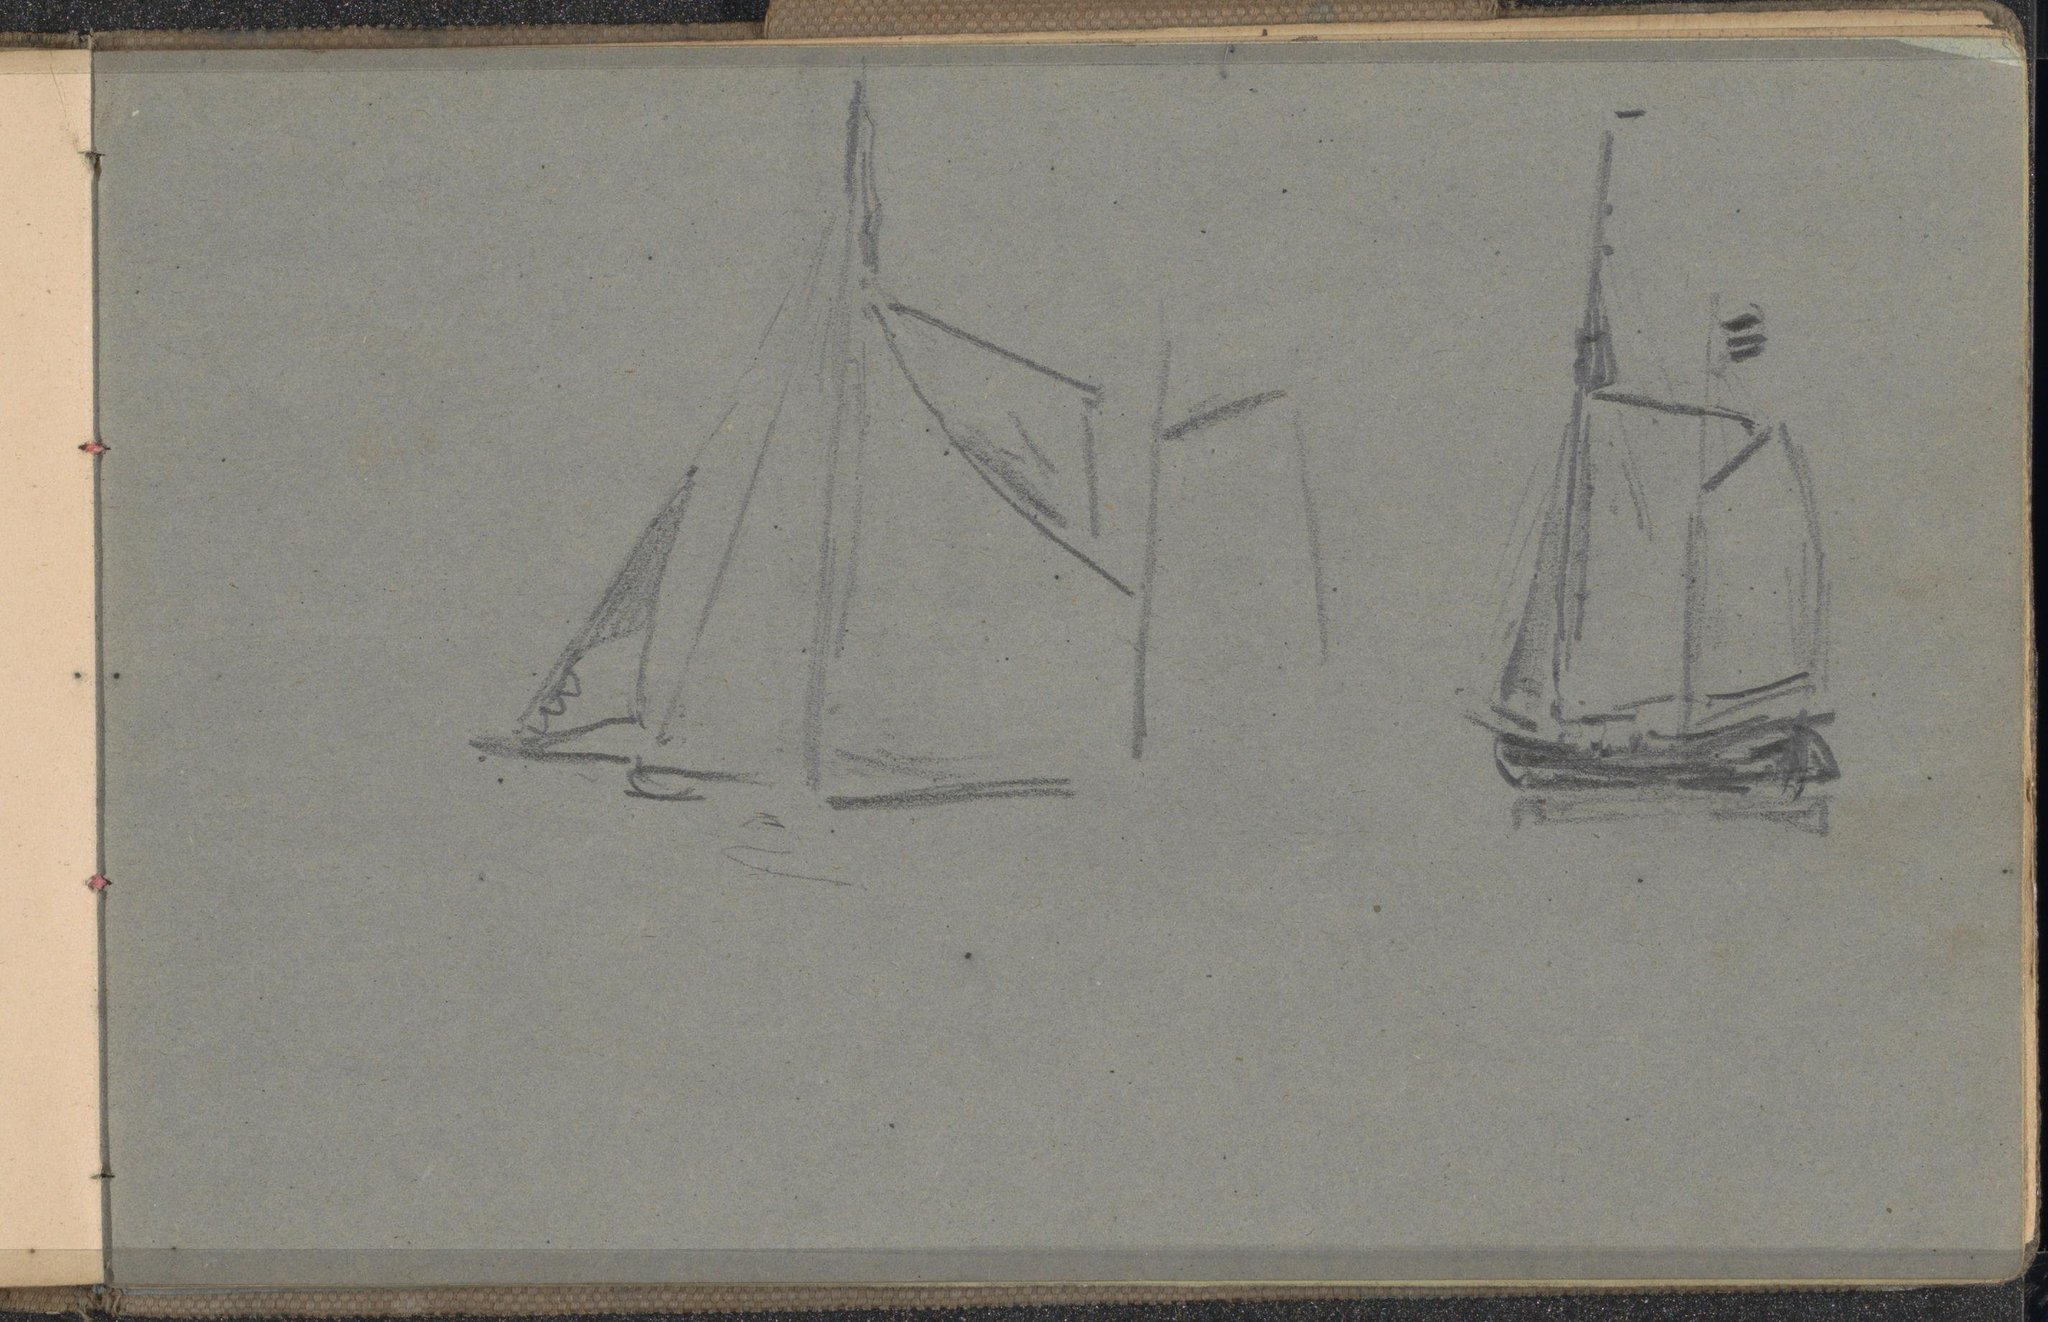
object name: sketchbook leaf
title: Studieblad met schepen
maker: louis apol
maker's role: draughtsman, painter, print maker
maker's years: 1850-1936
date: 1880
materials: paper, pencil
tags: ships (in general)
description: Blad 24 verso uit een schetsboek met 38 bladen betekend tijdens de expeditie naar Nova Zembla in 1880.